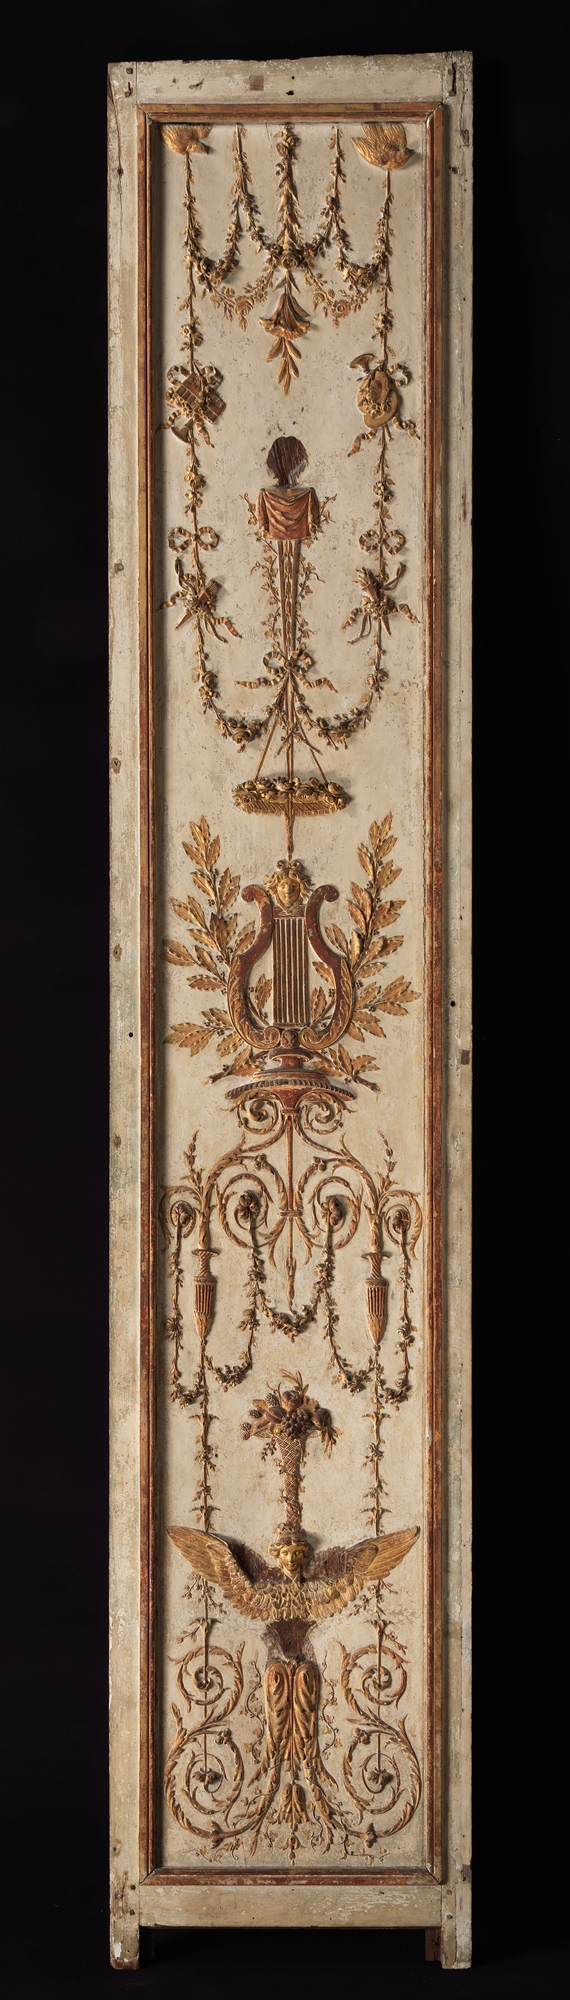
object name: panel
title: Pair of panels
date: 1701-1800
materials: wood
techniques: gilding, painting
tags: leaves